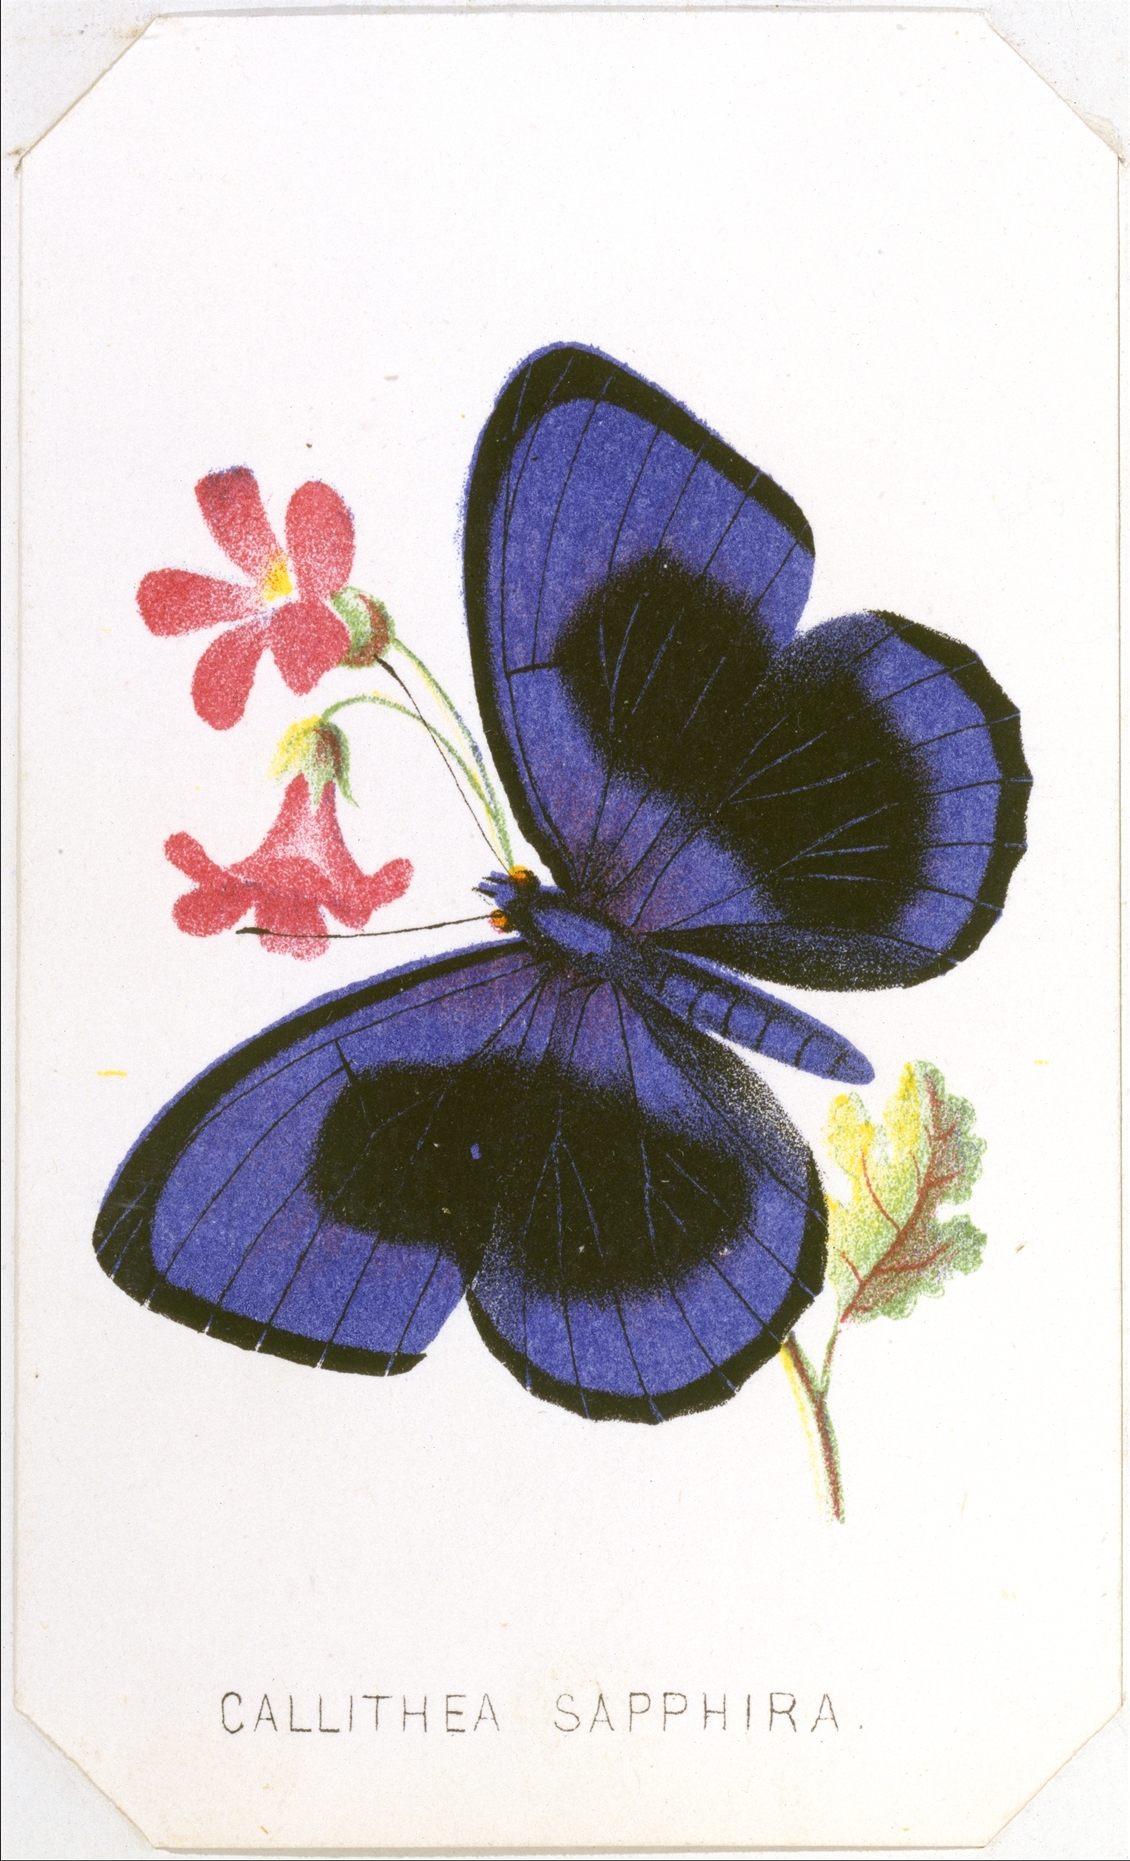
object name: print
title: Callithea Sapphira, from "The Butterflies and Moths of America", Part 1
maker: louis prang & co.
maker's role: publisher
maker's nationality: american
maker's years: 1800-1950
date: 1860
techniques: lithograph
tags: butterflies,flowers